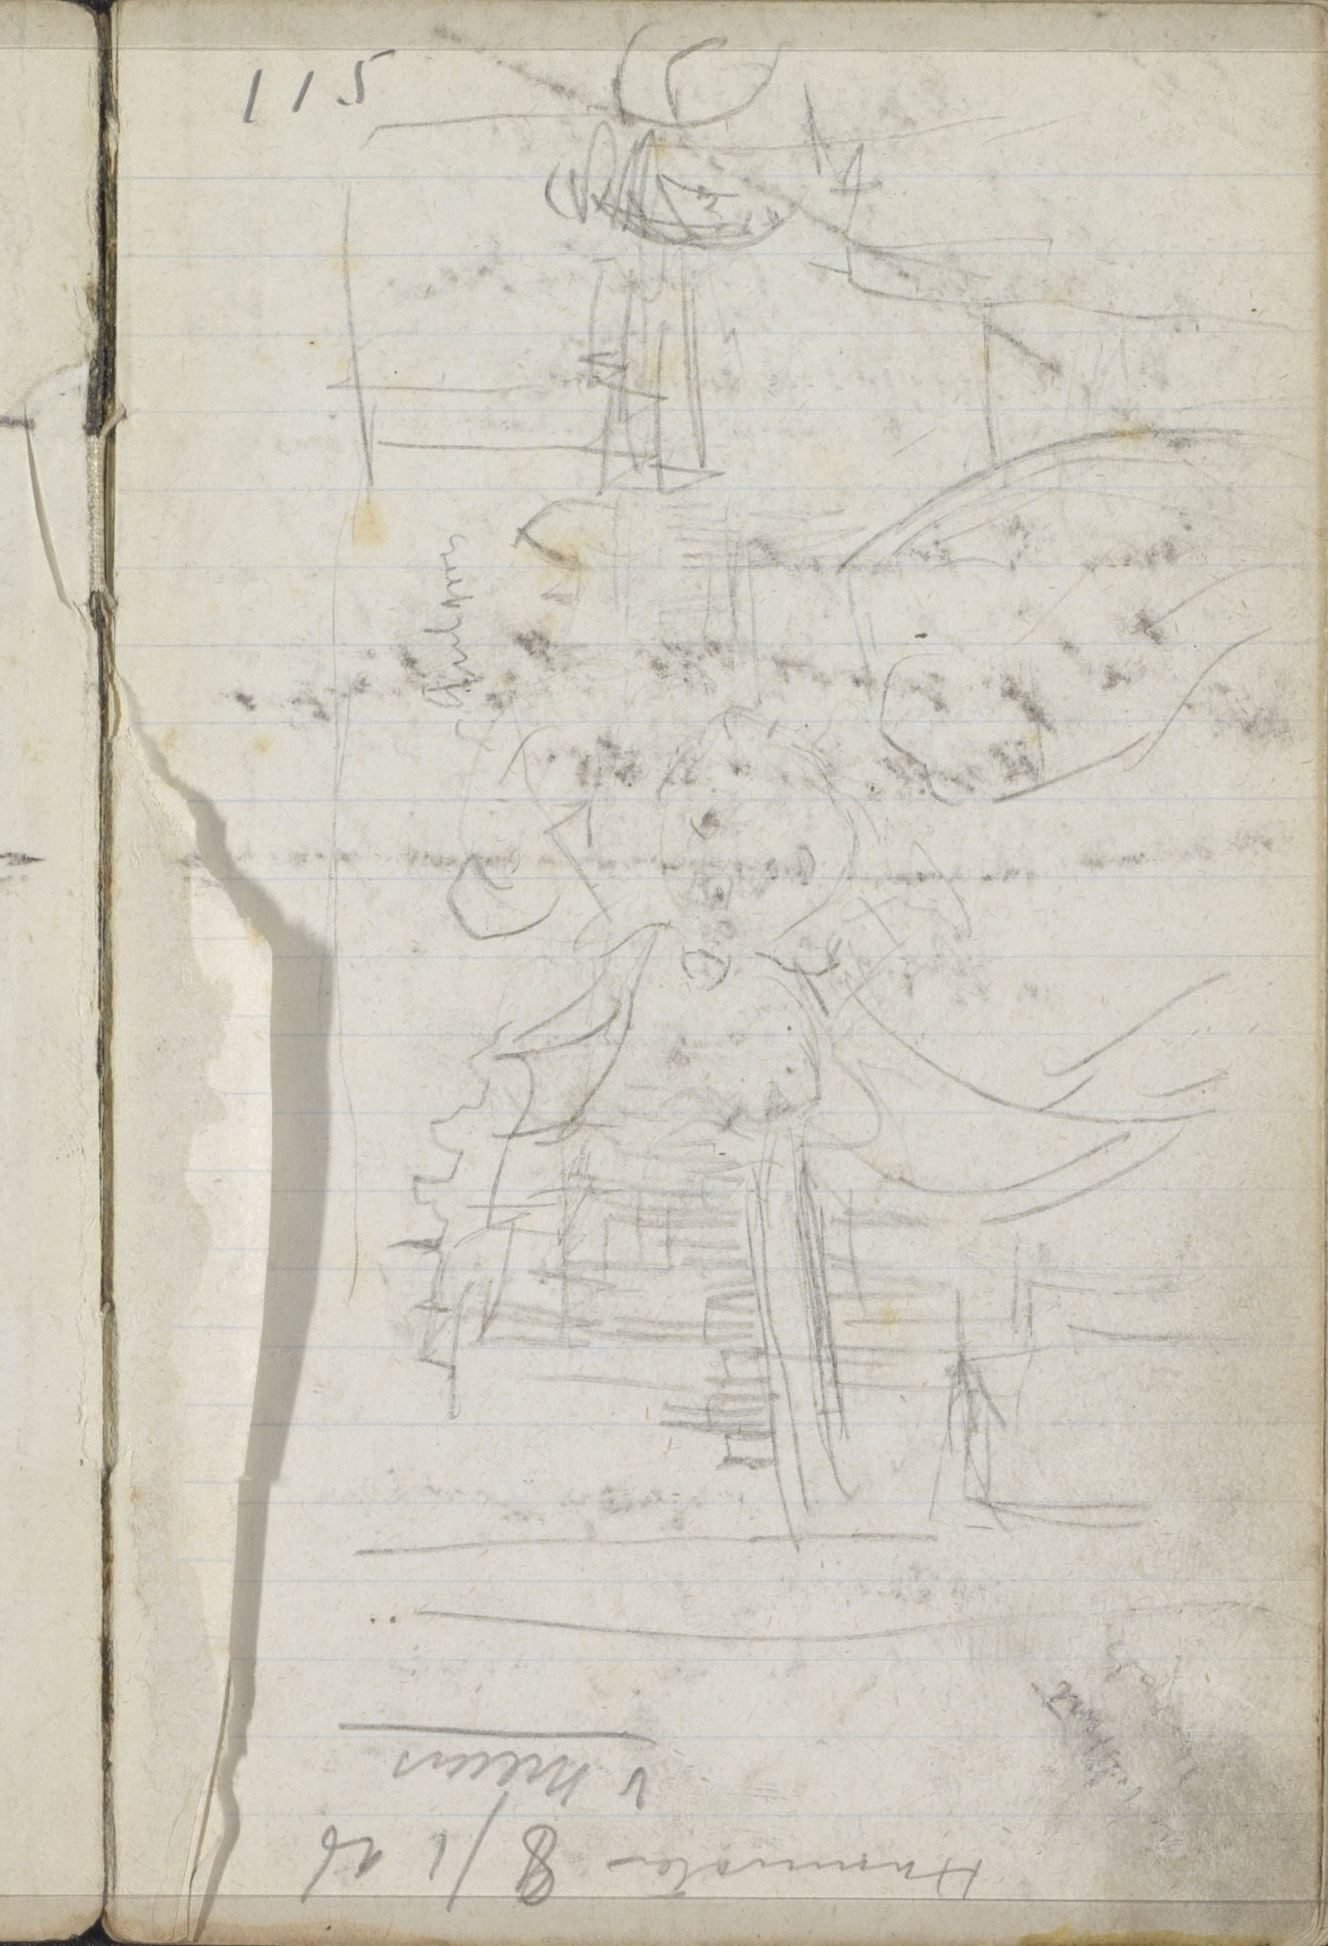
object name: sketchbook leaf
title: Figuren op het Rokin in Amsterdam, gezien vanuit de Bodega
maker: george hendrik breitner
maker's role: draughtsman, painter, print maker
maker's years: 1857-1923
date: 1893-1898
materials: paper, pencil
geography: amsterdam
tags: civic architecture; edifices; dwellings, canals, waters (in city) (+ city(-scape) with figures, staffage)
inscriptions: annotation: ‘[...]’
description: Pagina 2 uit een schetsboek met 31 bladen.